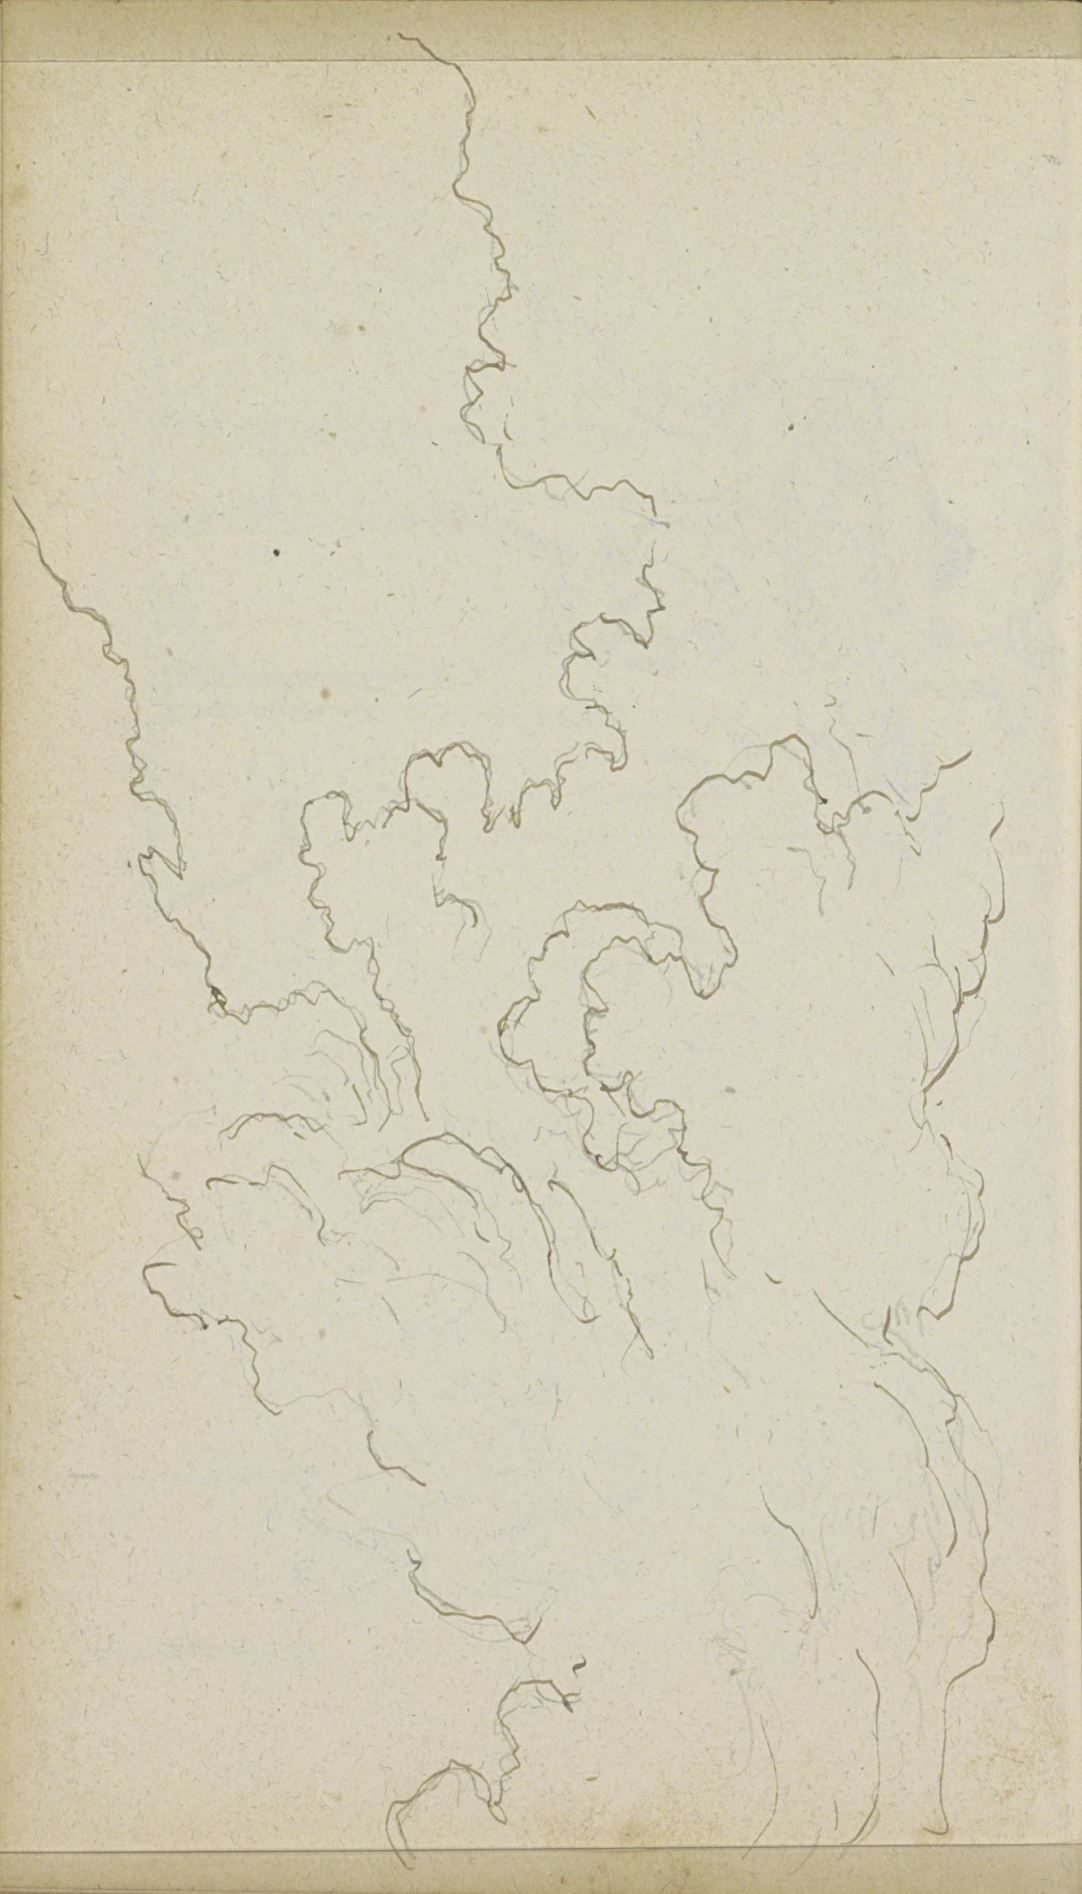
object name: sketchbook leaf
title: Wolkenlucht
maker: johannes tavenraat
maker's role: draughtsman, painter, print maker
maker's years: 1809-1881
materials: ink, paper, pencil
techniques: pen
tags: clouds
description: Blad 30 verso uit een schetsboek met 88 bladen.